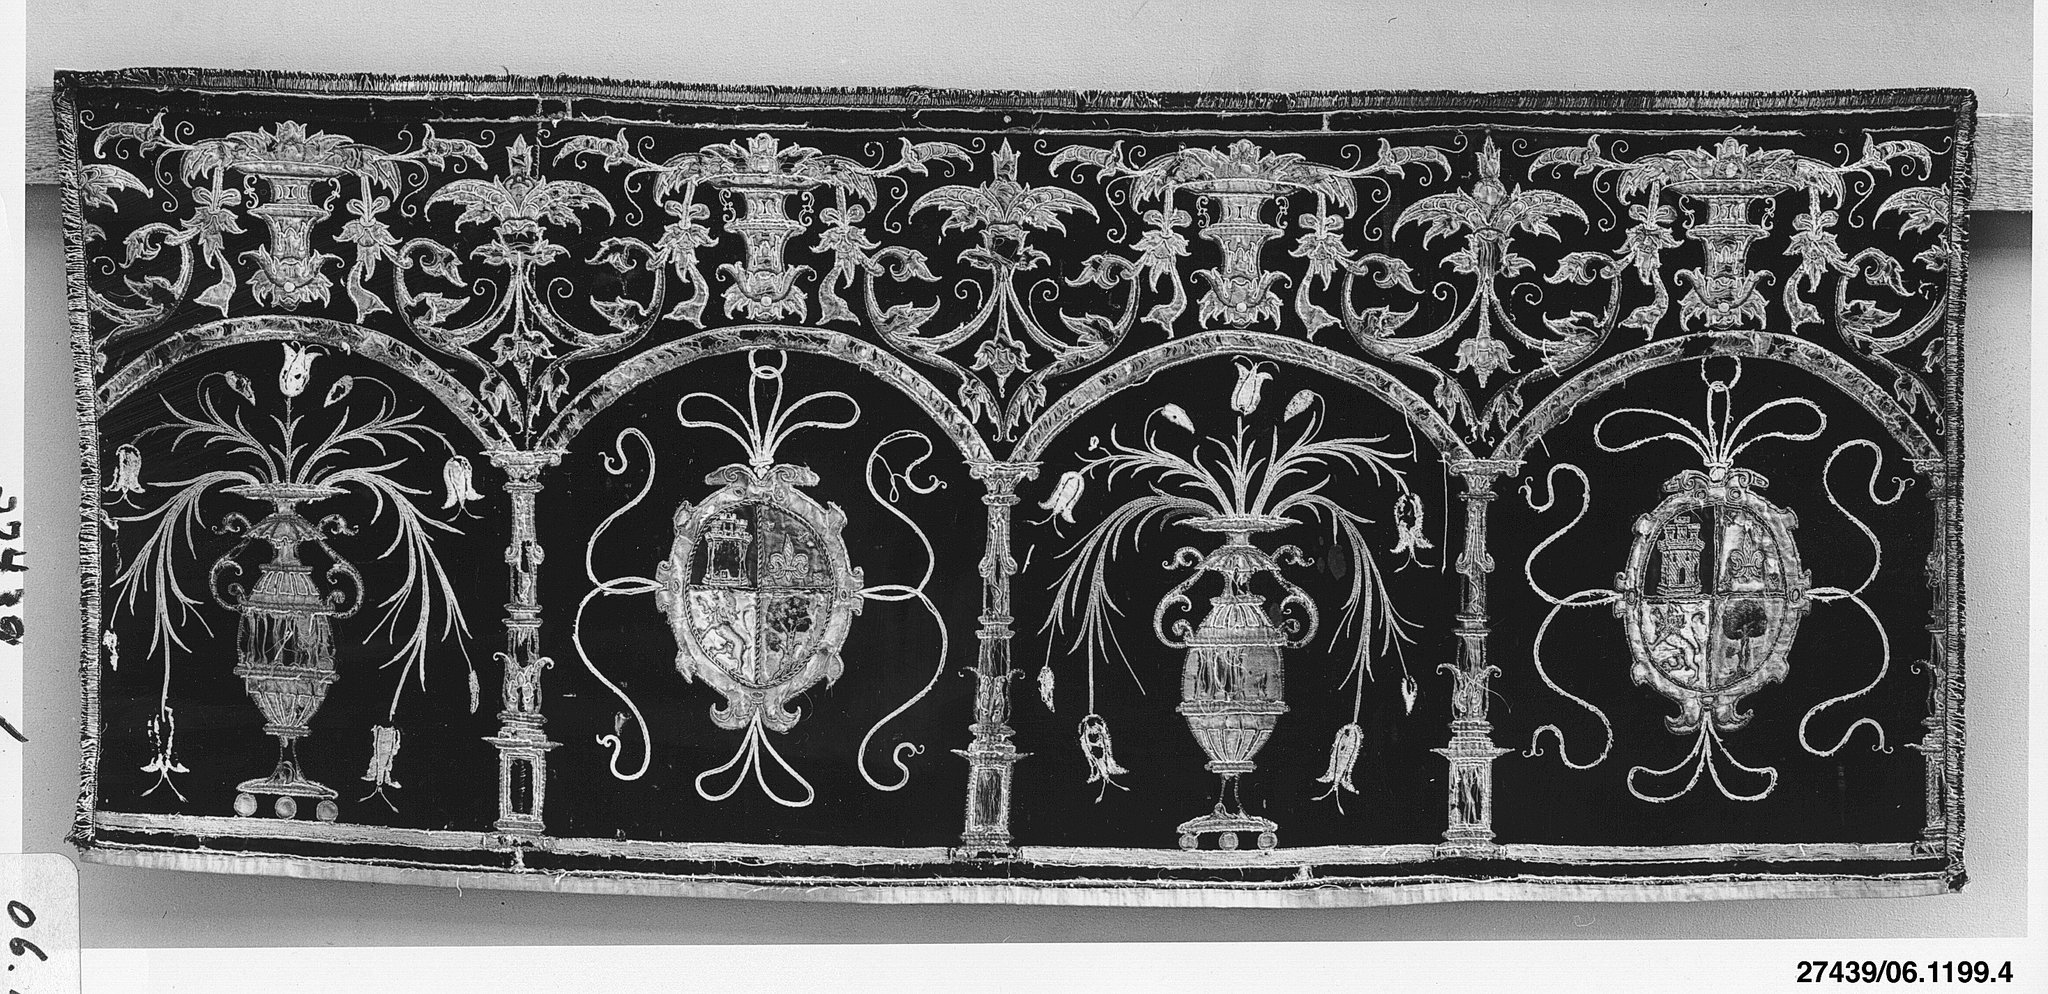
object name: altar frontal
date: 1501-1600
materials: metal thread, silk, velvet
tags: coat of arms